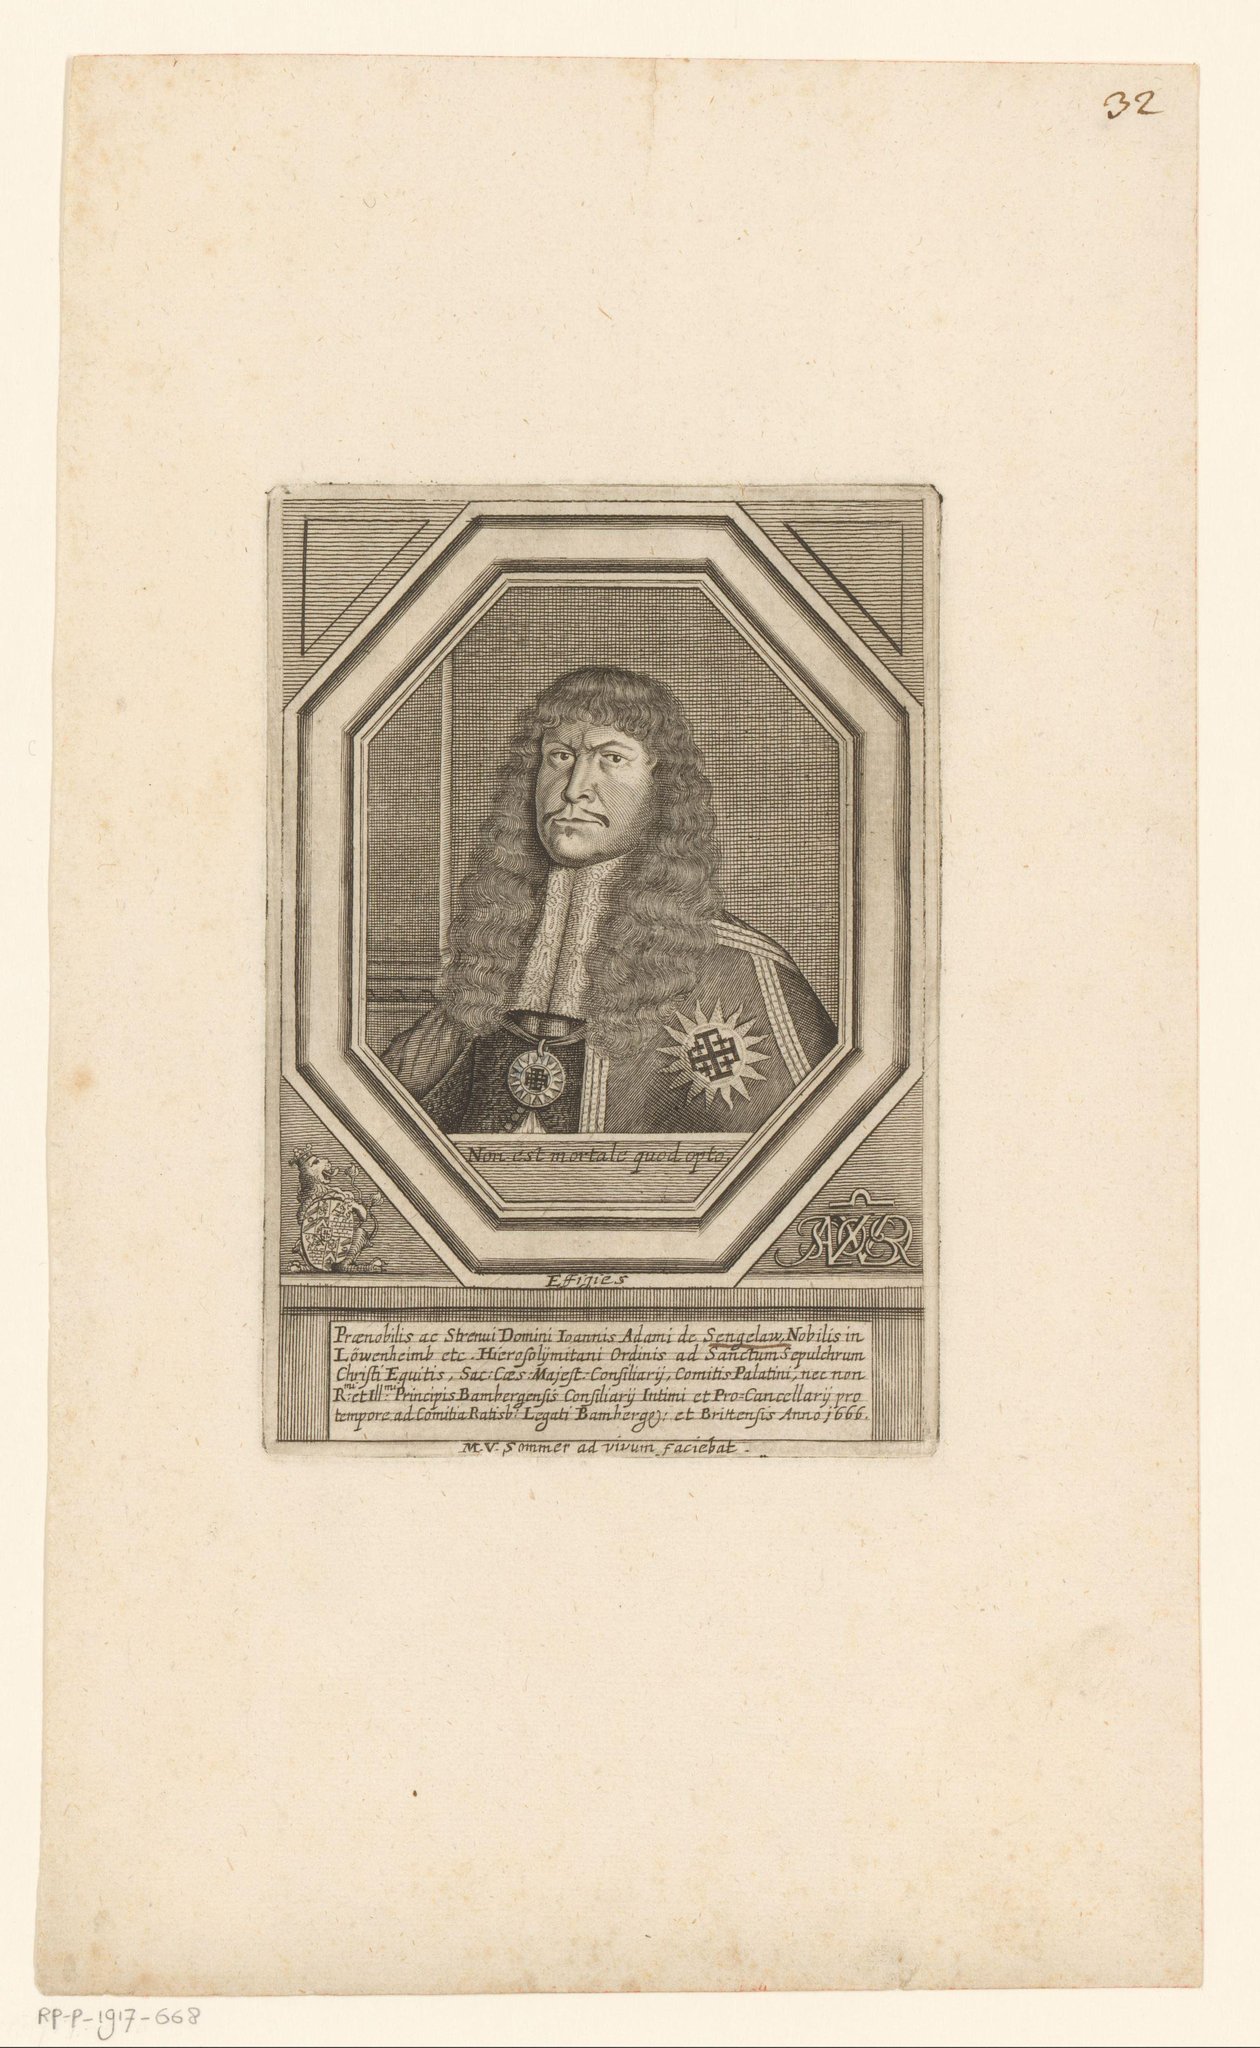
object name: print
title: Portret van Johann Adam von Sengelau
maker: matthias van sommer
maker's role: draughtsman, print maker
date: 1666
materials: paper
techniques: engraving, intaglio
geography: germany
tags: historical persons, armorial bearing, heraldry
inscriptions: collector's mark: Lugt 2228, number: ‘32’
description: Volgens Hollstein werd de prent gebruikt voor de publicatie: Sommer, Matthias van. Hasce Omnium Electorum. Regensburg: s.n., 1667. Alhoewel op de titelpagina van de publicatie het jaar 1667 wordt vermeld, zijn meerdere prenten later gedateerd. Waarschijnlijk werd de publicatie pas in 1671 daadwerkelijk uitgegeven.